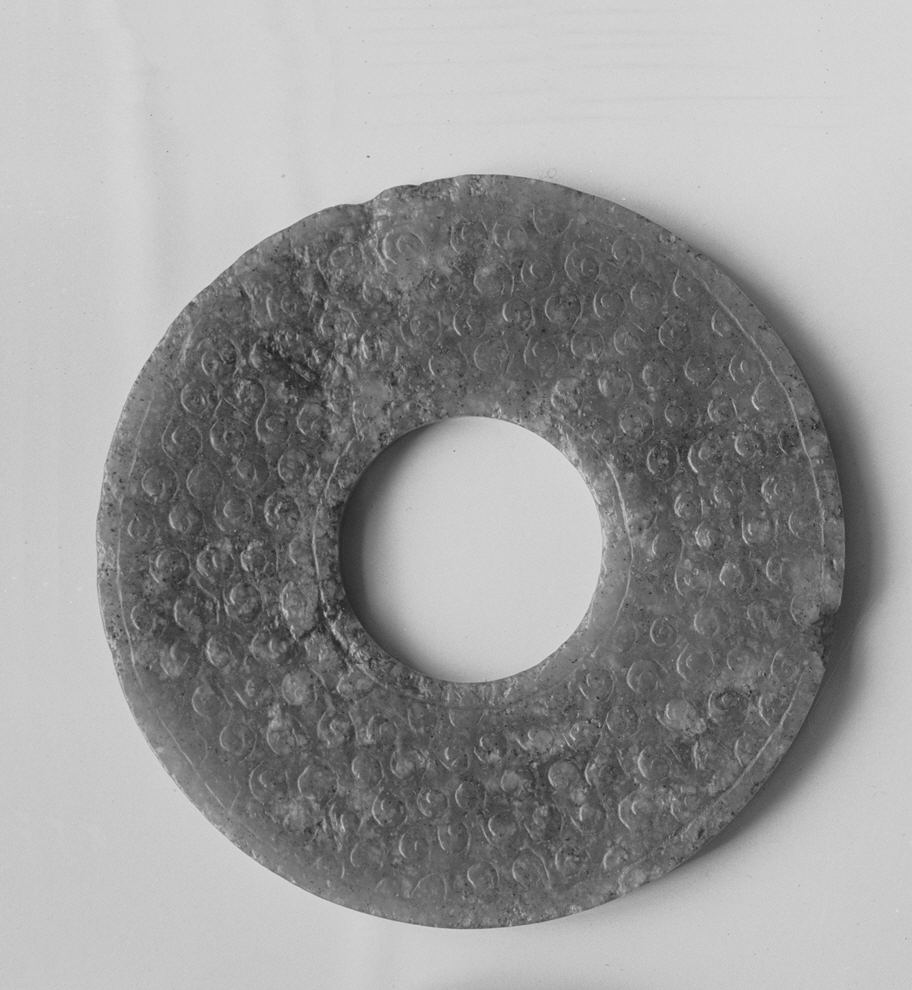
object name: disk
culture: chinese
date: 1-200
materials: jade